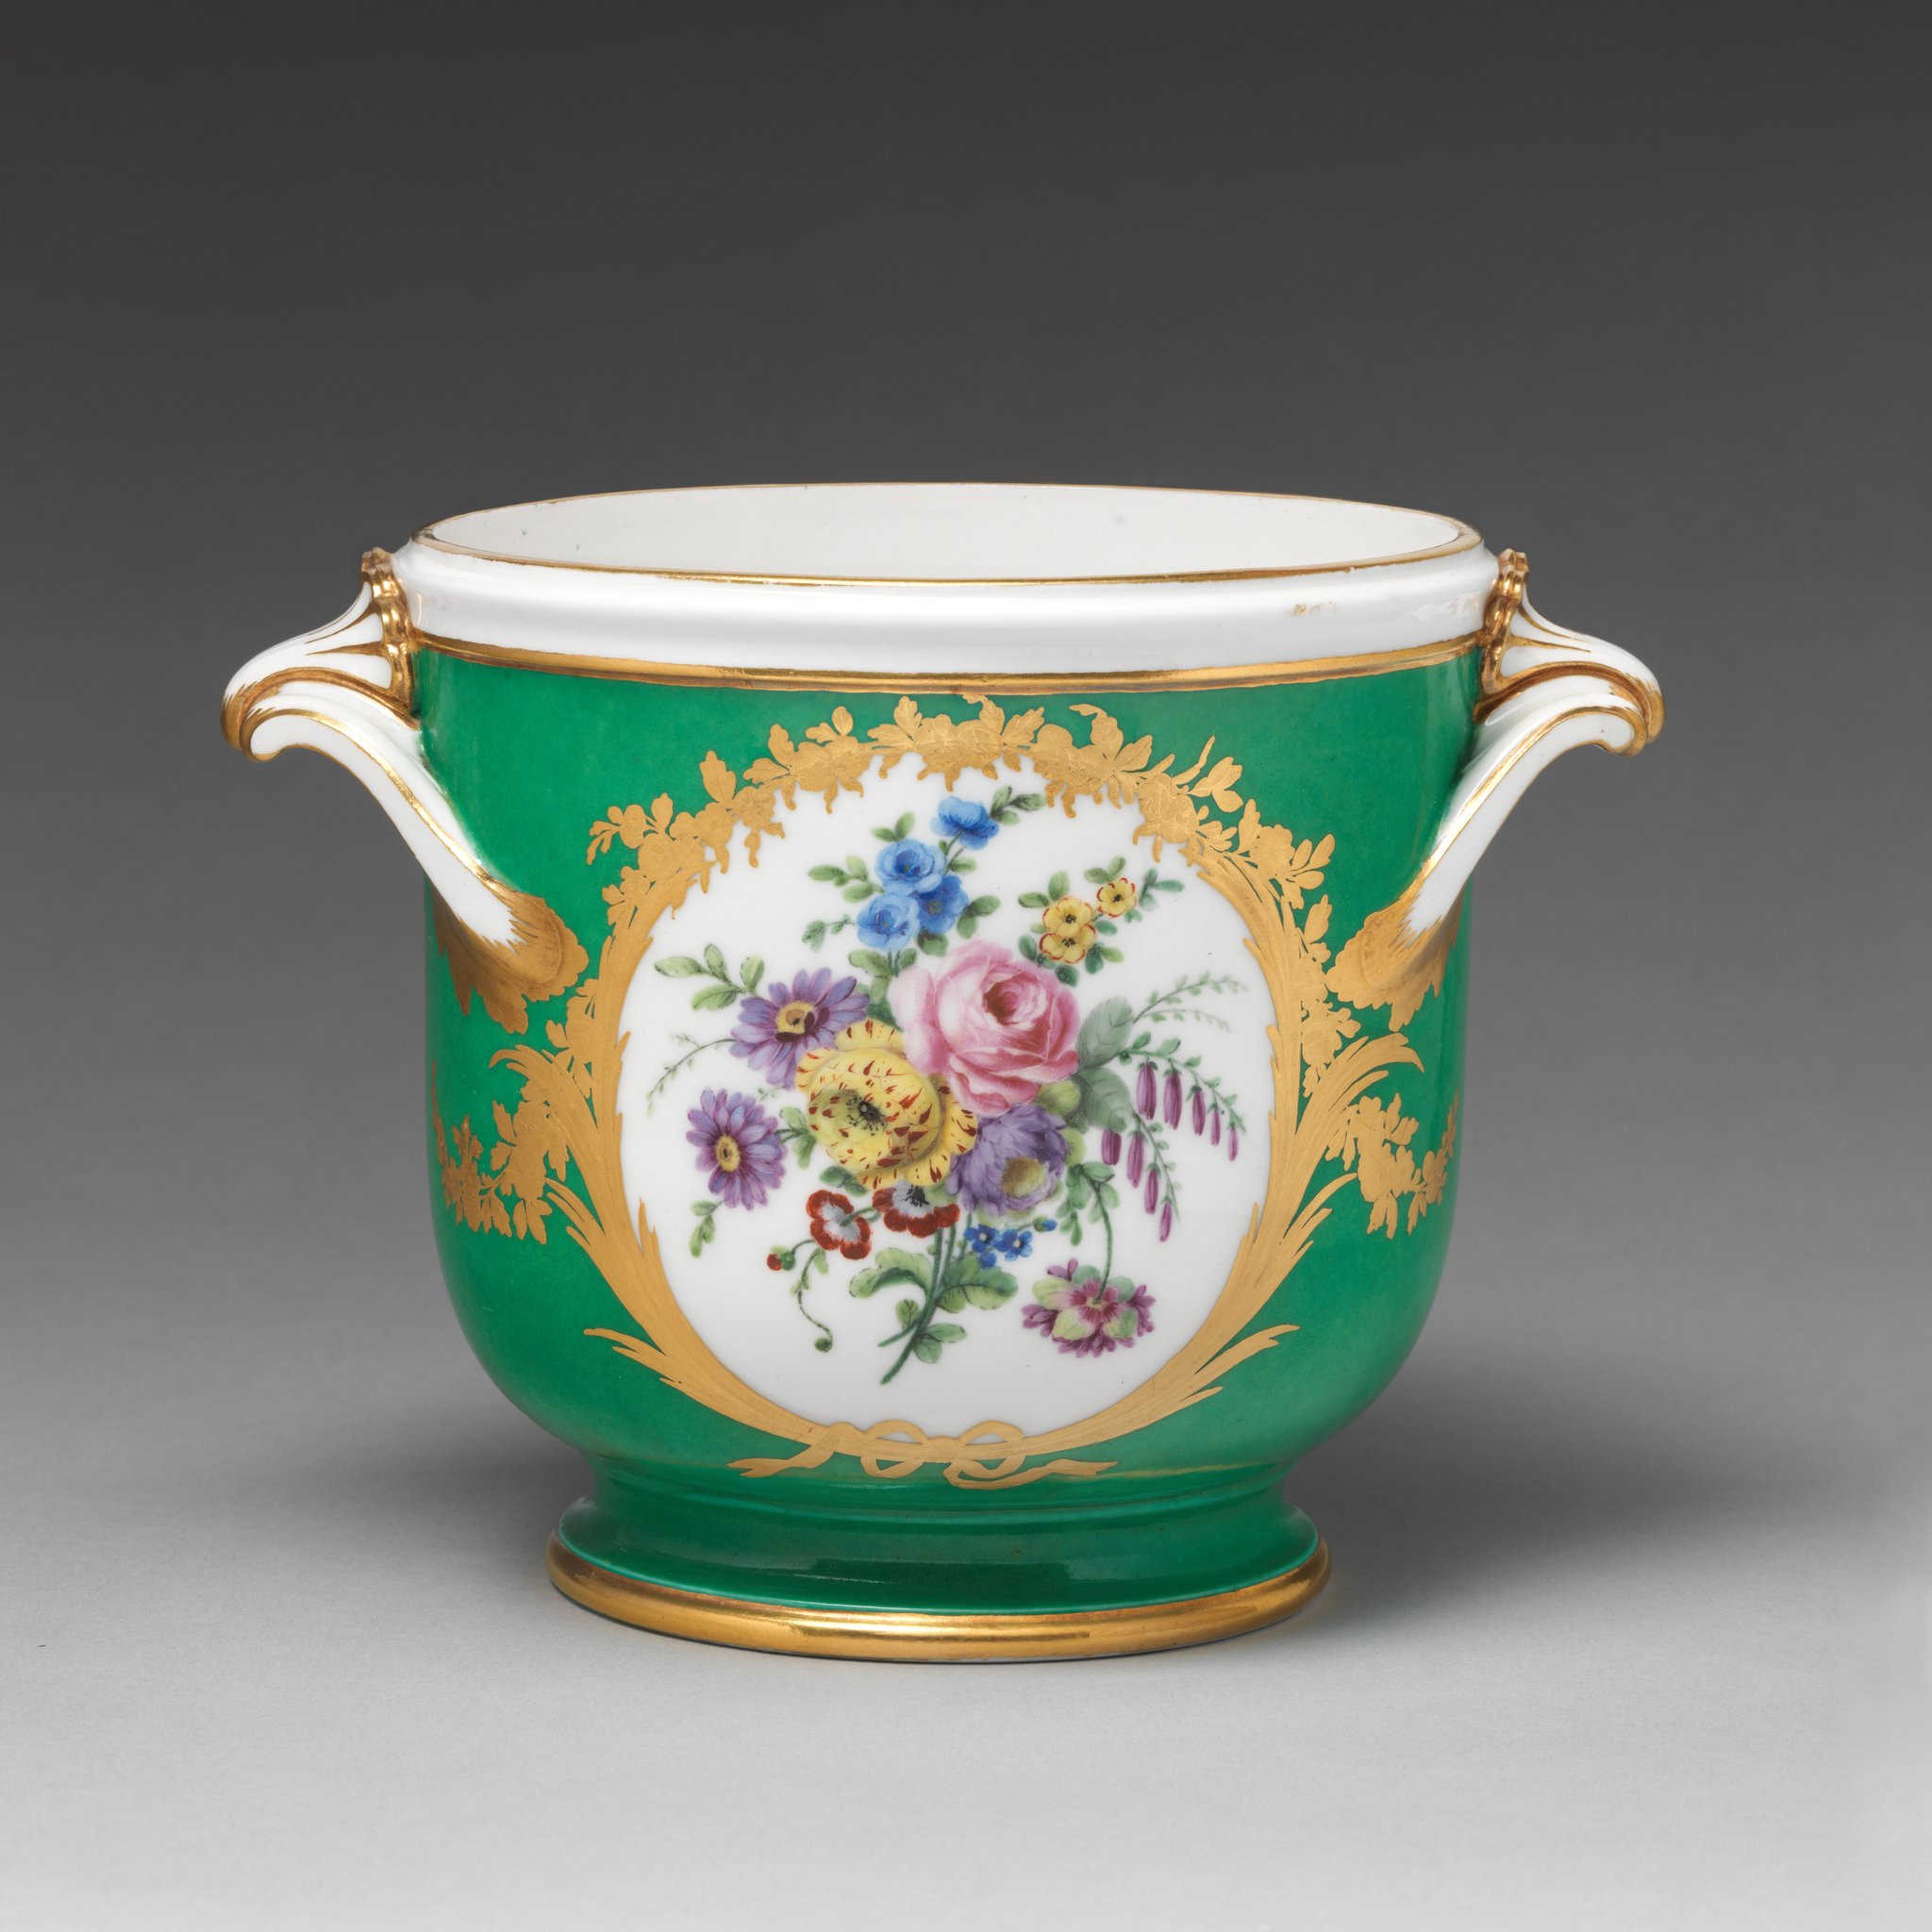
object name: half bottle cooler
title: Half-bottle cooler (seau à demi-bouteille) (one of two) (part of a service)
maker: sèvres manufactory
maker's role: manufactory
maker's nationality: french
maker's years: 1740-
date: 1780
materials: soft paste porcelain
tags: flowers